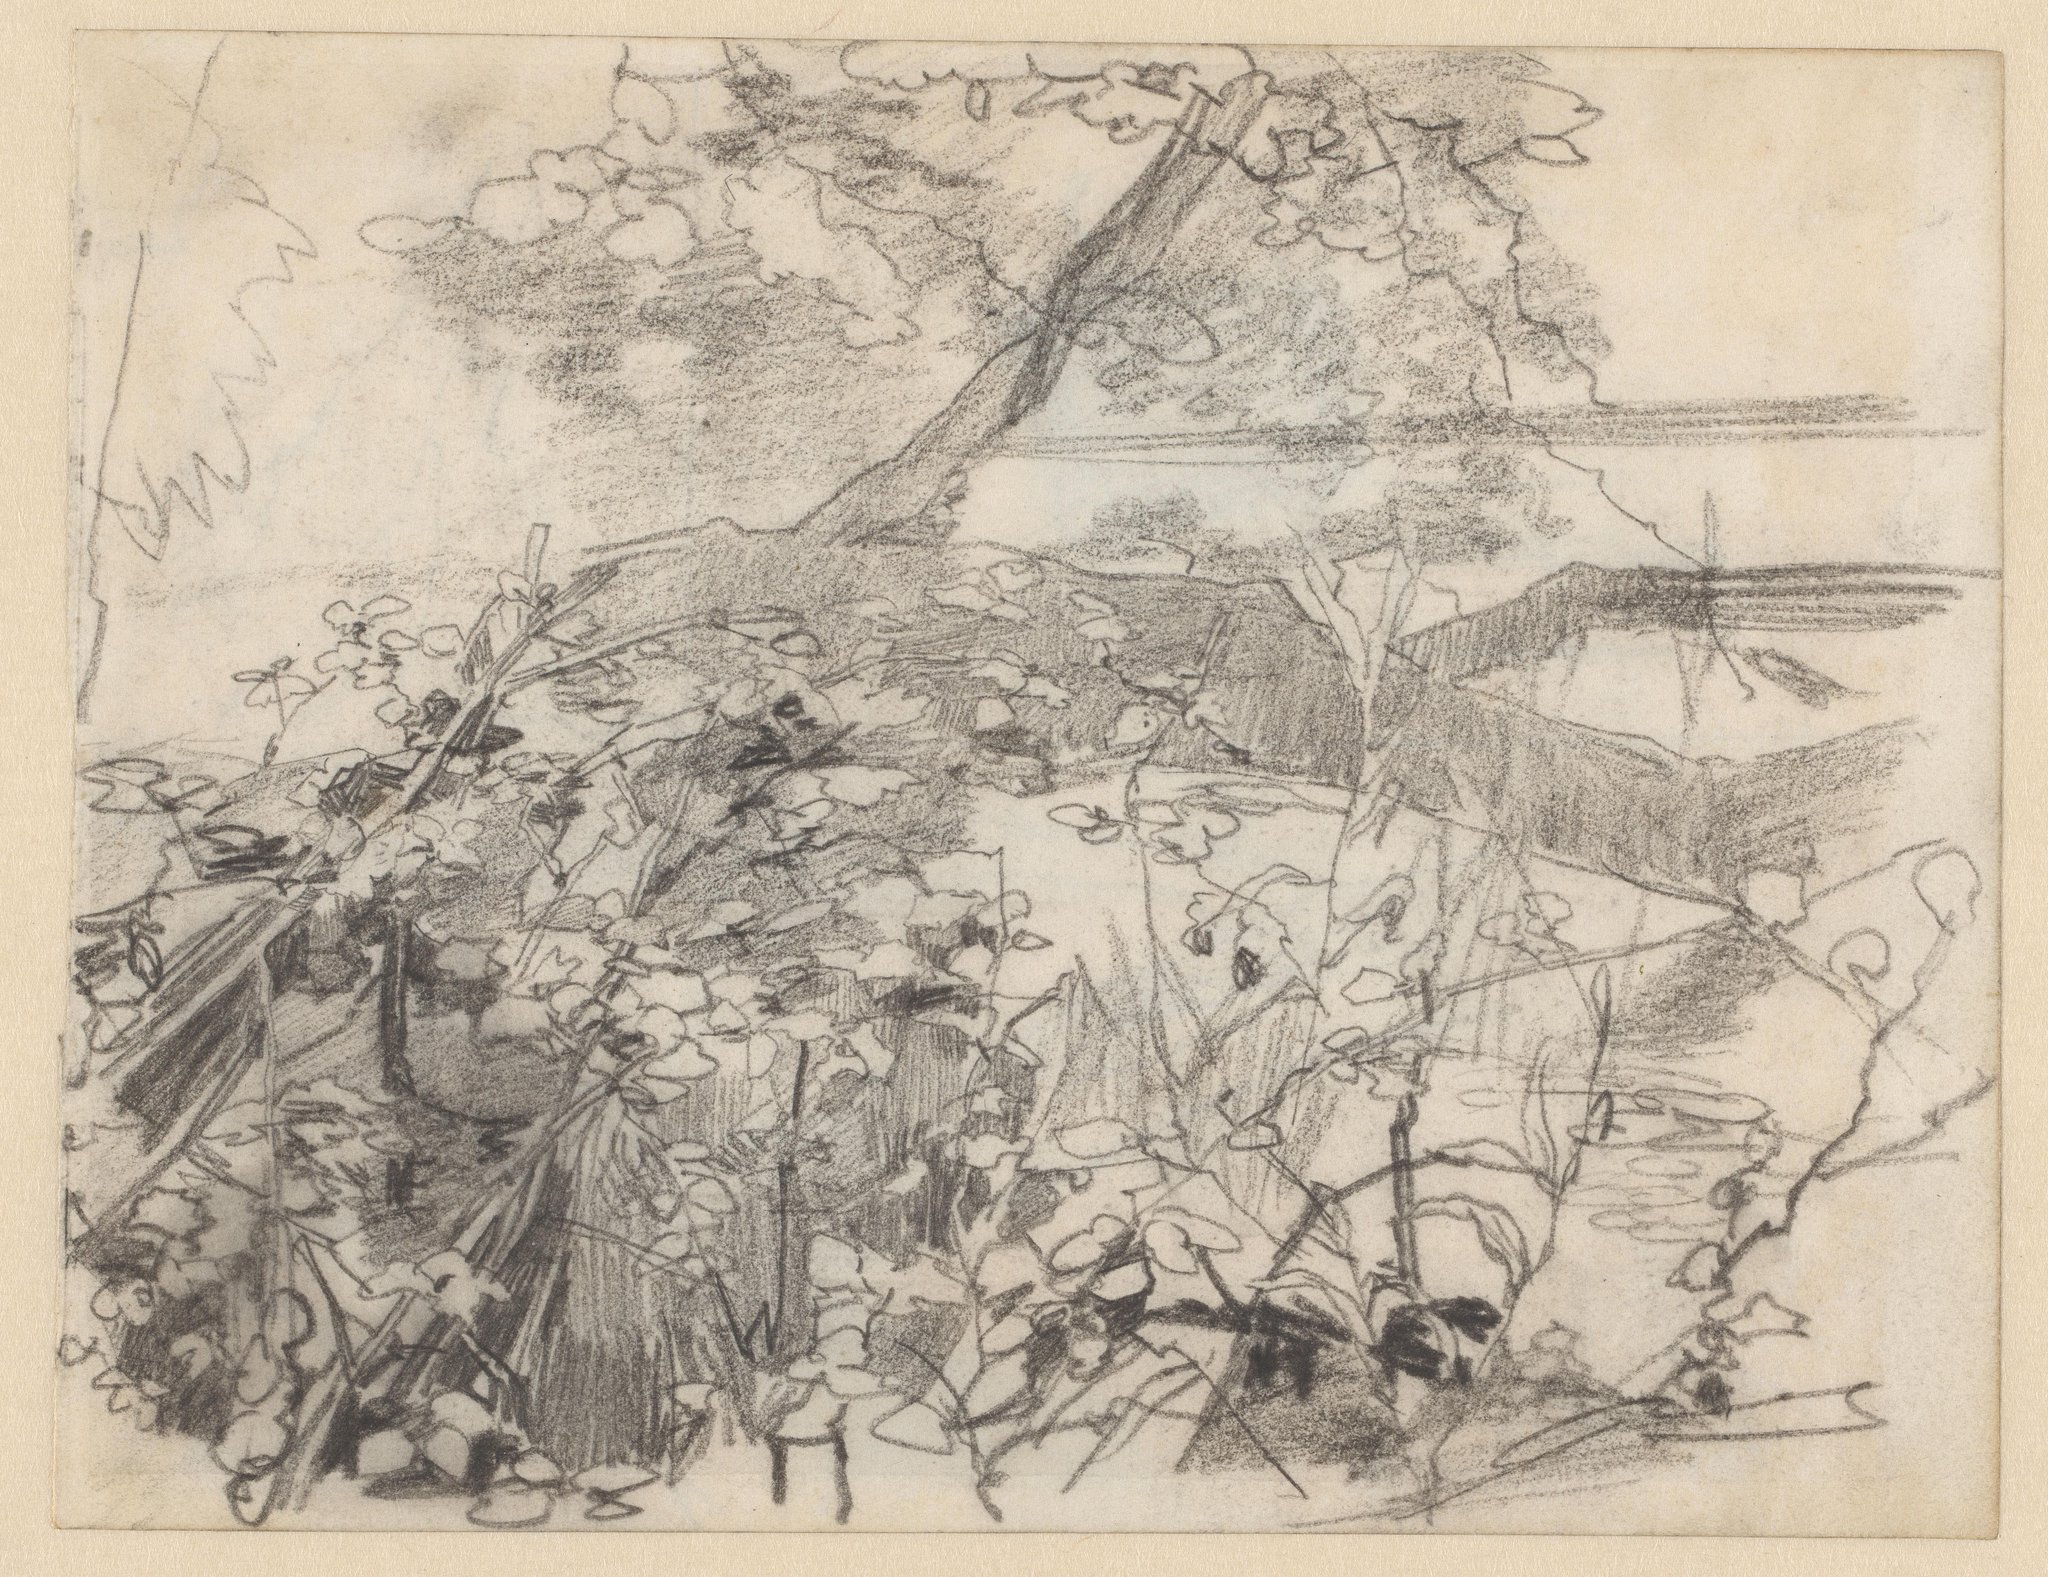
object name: drawing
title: Landschap met een omgevallen boom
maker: matthijs maris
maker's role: draughtsman, painter, print maker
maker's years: 1839-1917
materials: chalk, paper